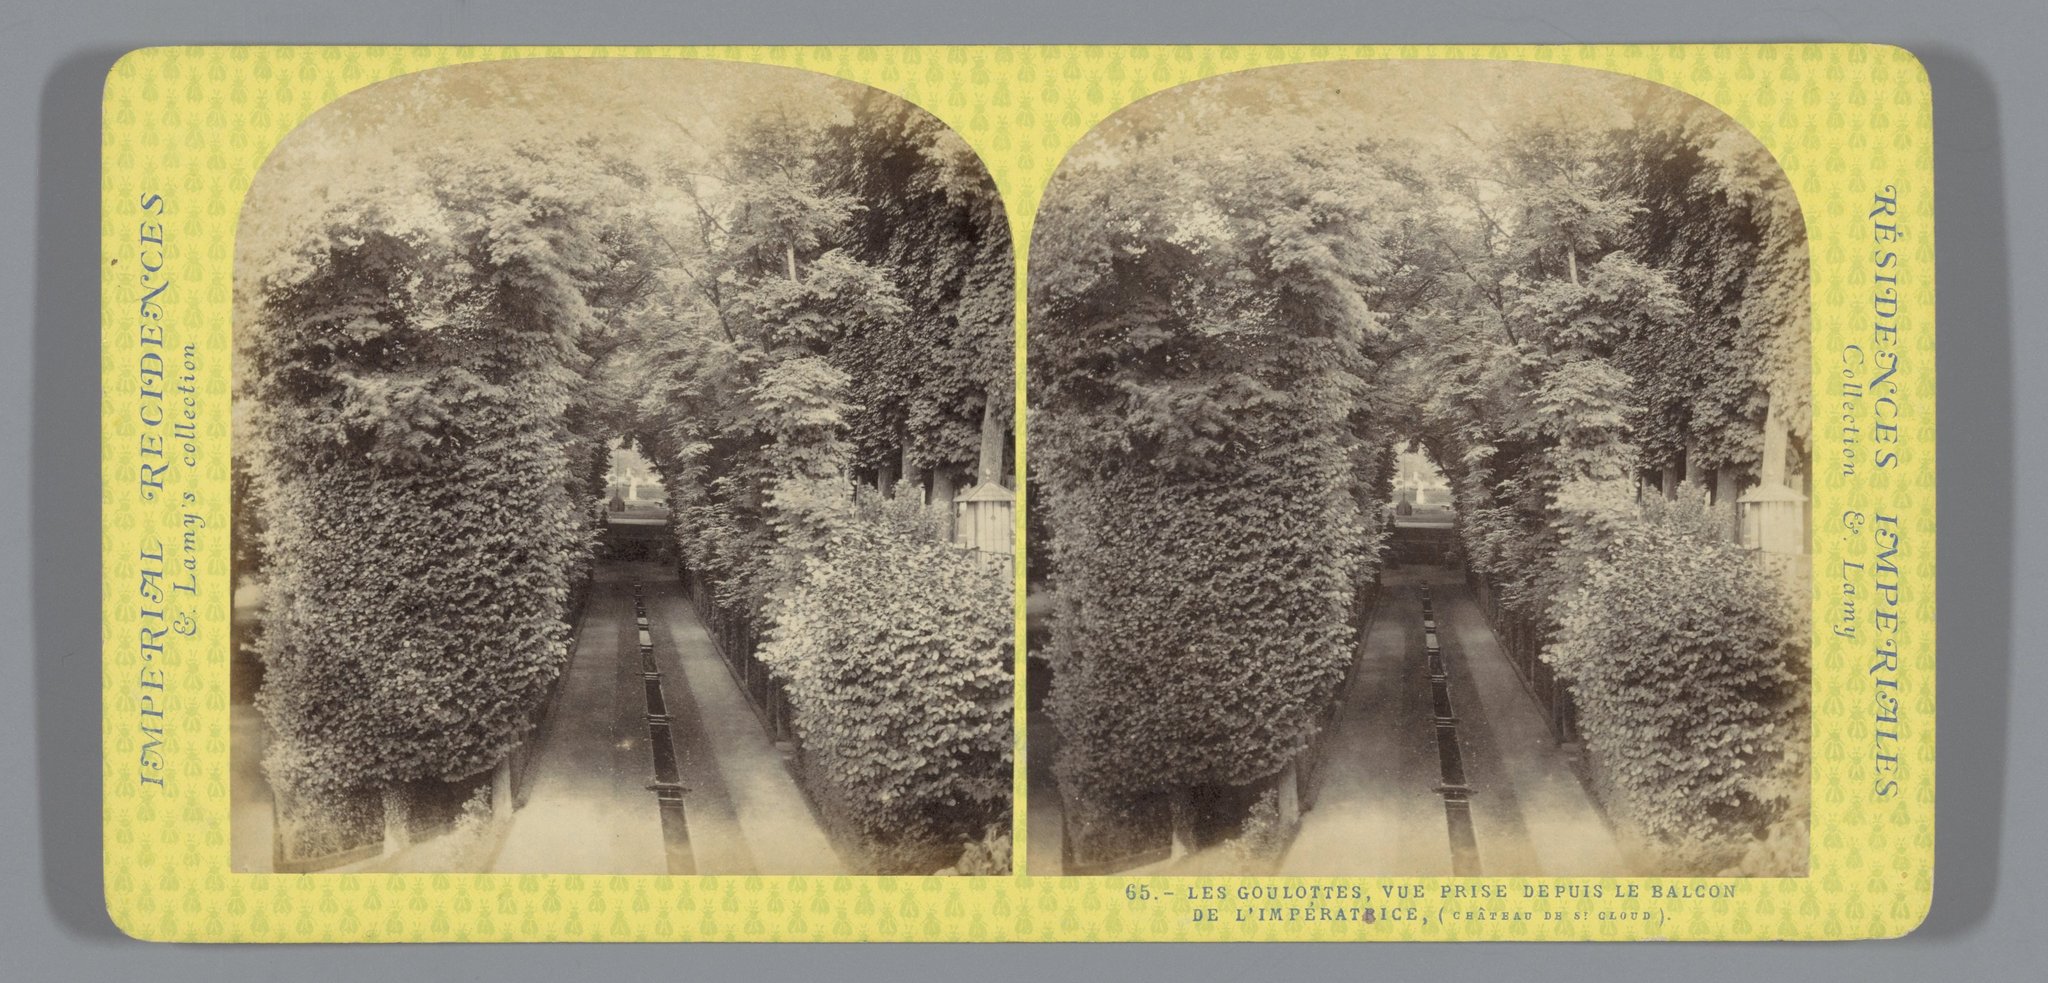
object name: stereograph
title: Les Goulottes, Vue prise depuis le Balcon de l'Imperatrice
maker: ernest eléonor pierre lamy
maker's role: publisher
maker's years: 1828-1900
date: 1860-1870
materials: cardboard, photographic support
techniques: albumen print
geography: château de saint-cloud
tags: garden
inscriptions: number: ‘65.’, inscription: ‘E. Lamy's collection’